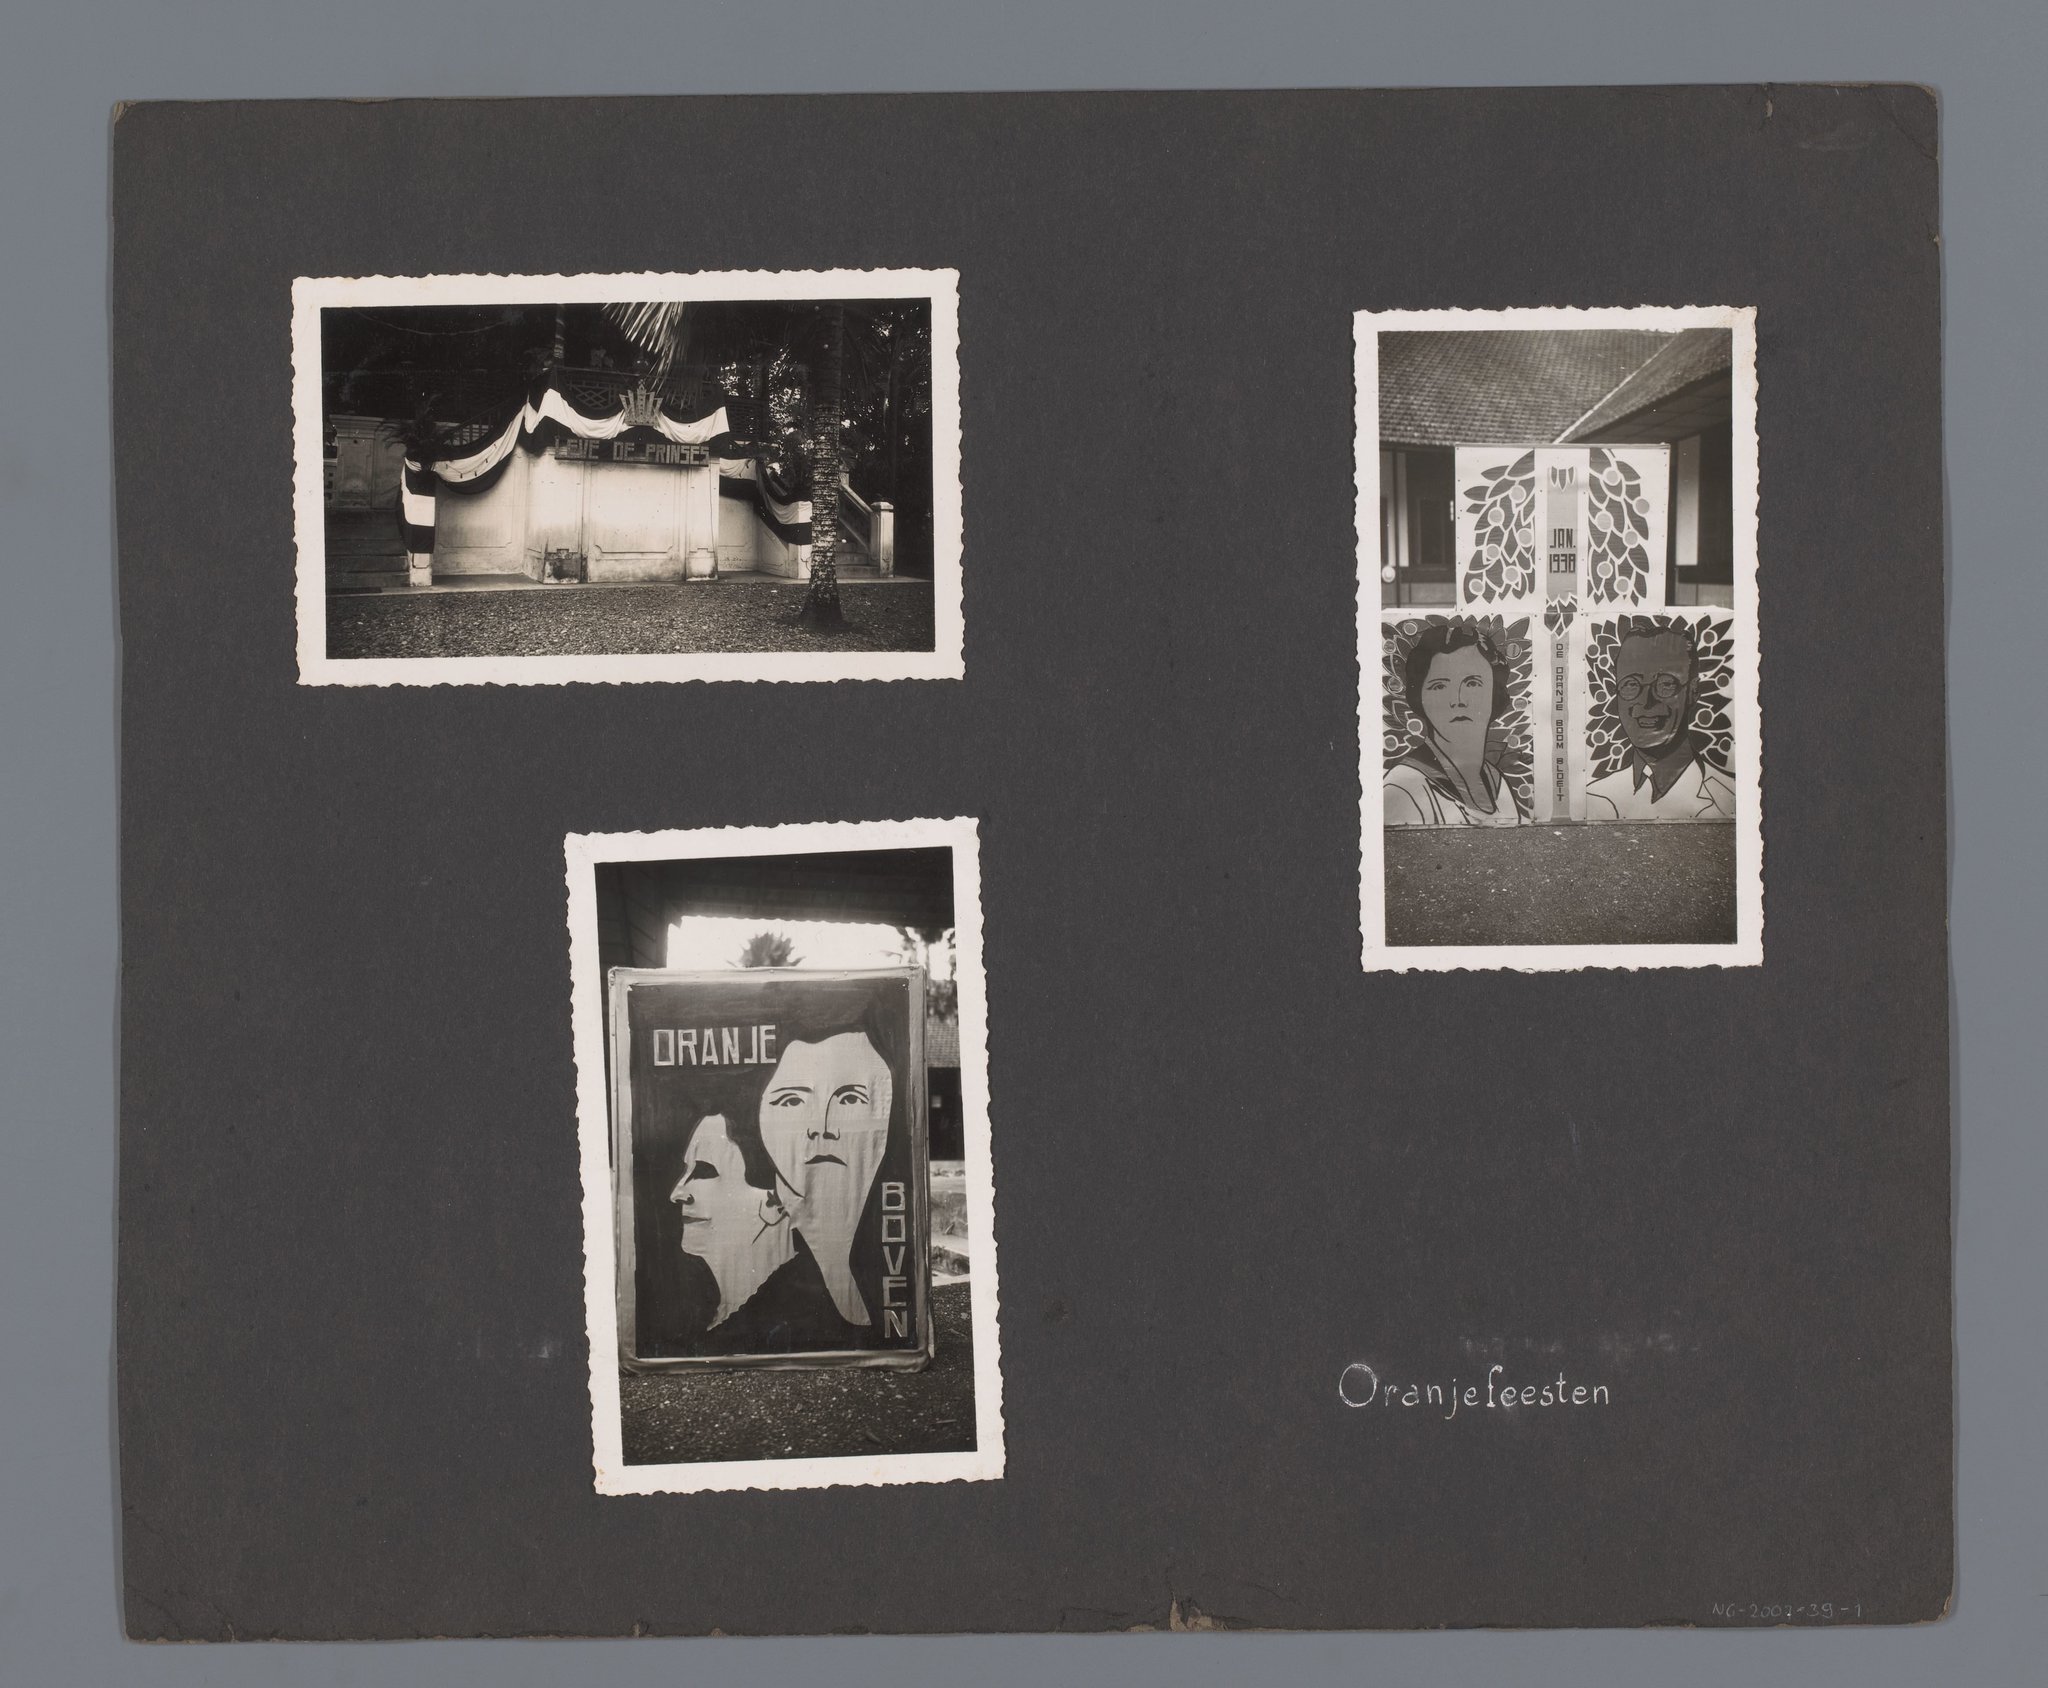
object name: photograph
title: Oranjefeesten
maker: Anonymous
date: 1902-1938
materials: paper, photographic support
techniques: gelatin silver print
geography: dutch east indies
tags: the hague, print maker, wilhelmina of the netherlands, utrecht, bernhard (prins der nederlanden), beatrix (koningin der nederlanden), juliana of the netherlands, public festivities on the occasion of royal events, dutch east indies, the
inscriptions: annotation: ‘Oranjefeesten’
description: Albumblad met drie foto's van versieringen voor een Oranjefeest ter gelegenheid van de geboorte van prinses Beatrix op 31 januari 1938. Onderdeel van het losbladig fotoalbum over de Fraters van Tilburg op Celebes en Sumatra.